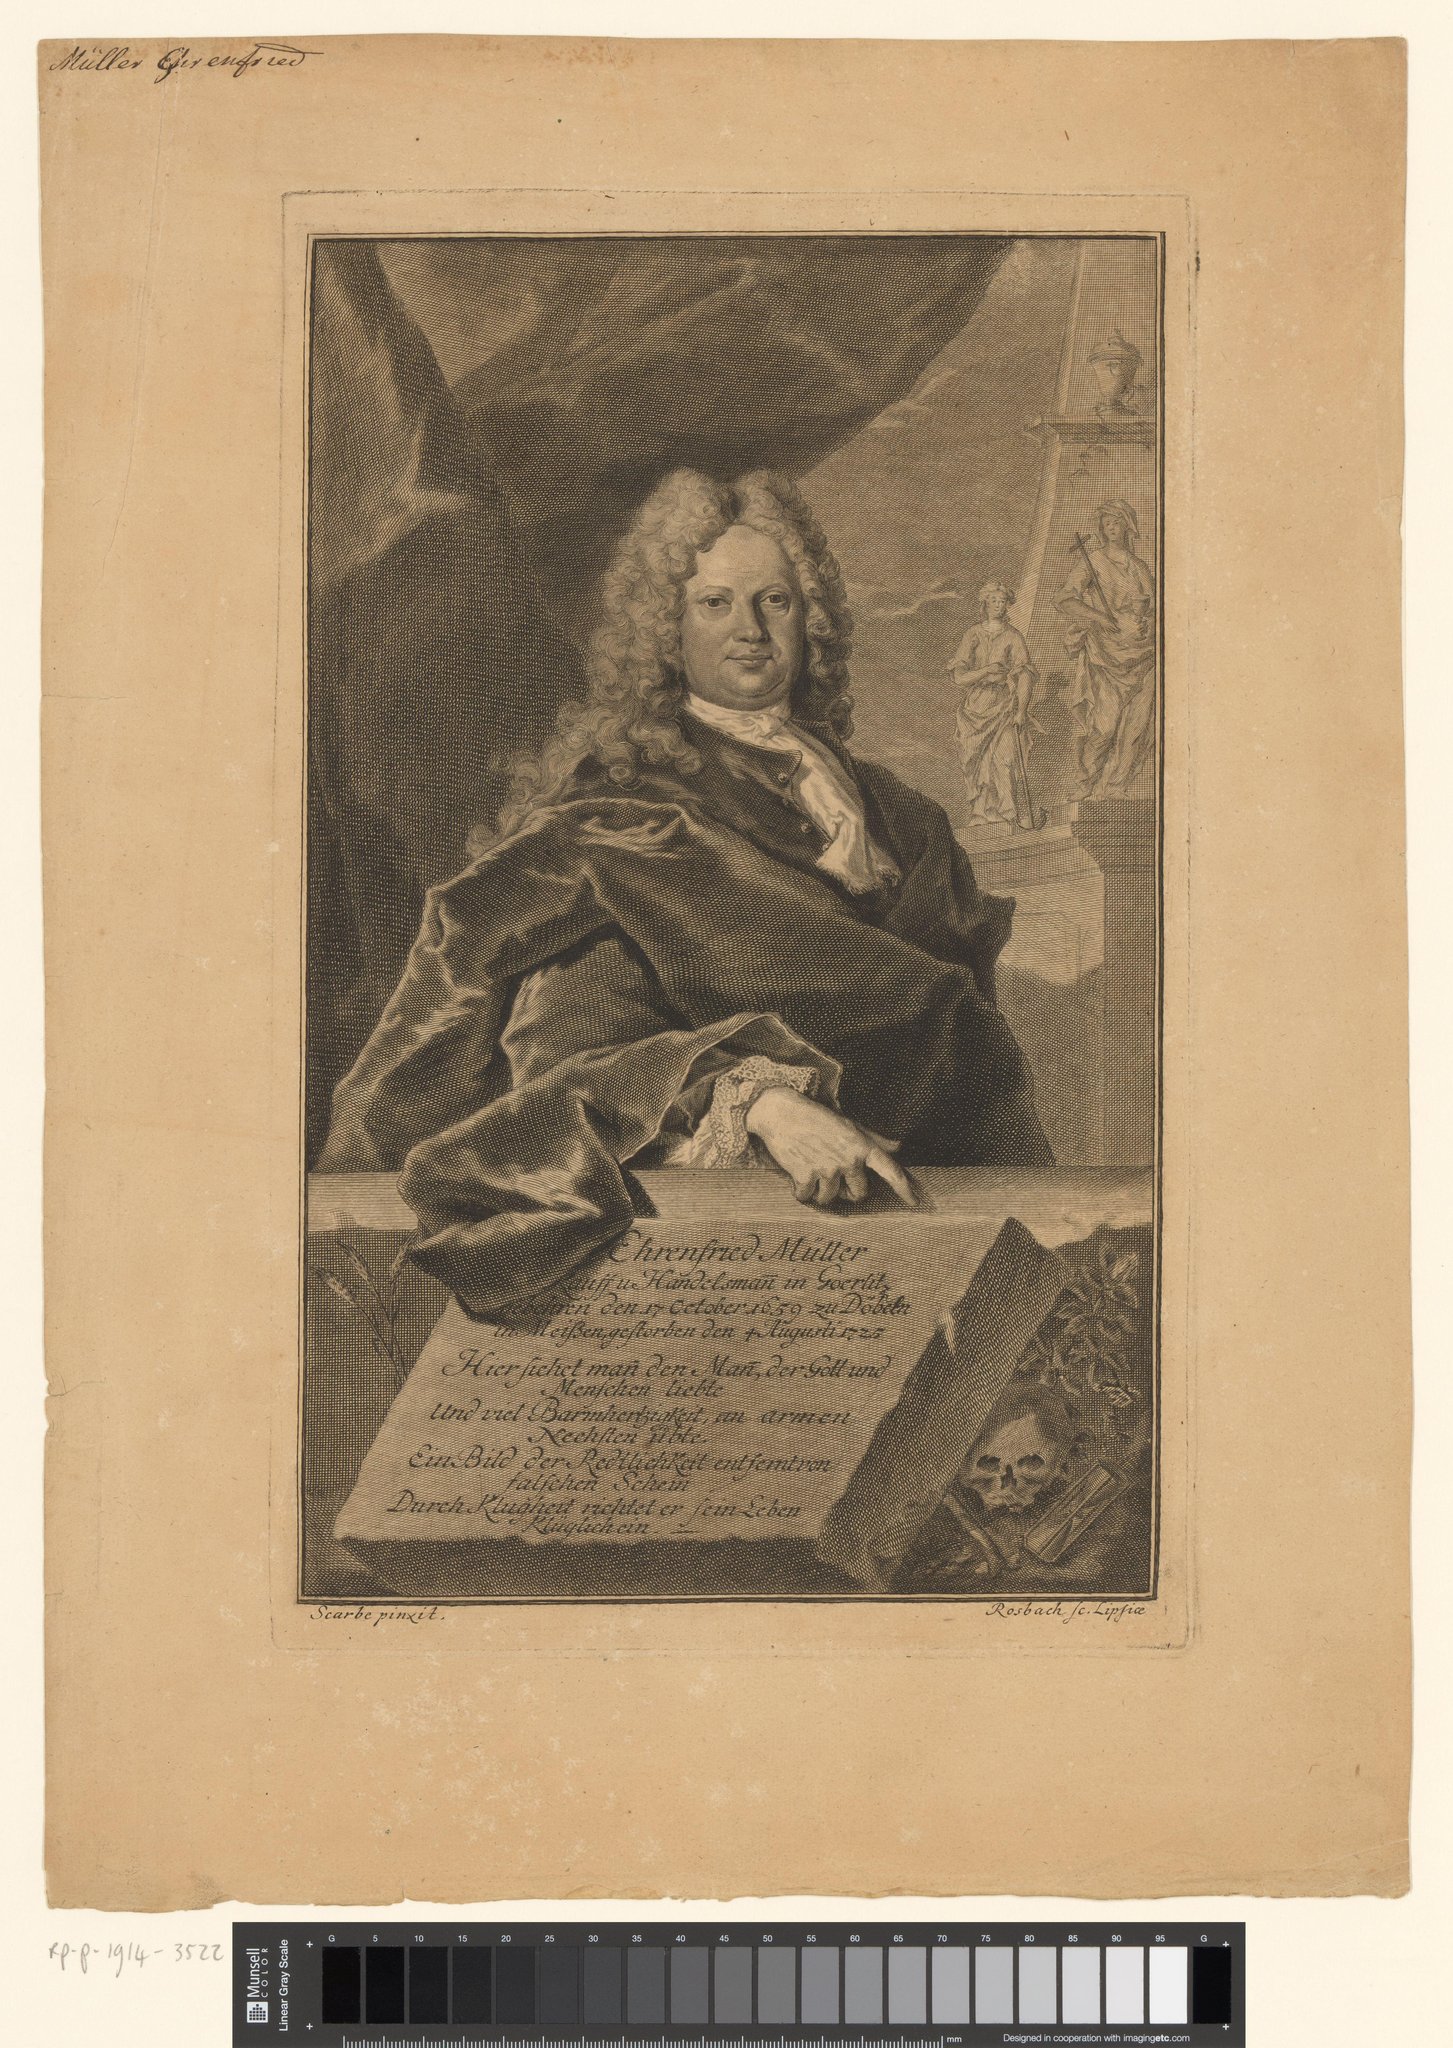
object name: print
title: Portret van Ehrenfried Müller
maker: johann friedrich rosbach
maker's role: print maker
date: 1725-1749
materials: paper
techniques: engraving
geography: leipzig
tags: obelisk, needle, historical persons, hourglass, death's head, skull (symbol of death)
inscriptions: collector's mark: Lugt 2228